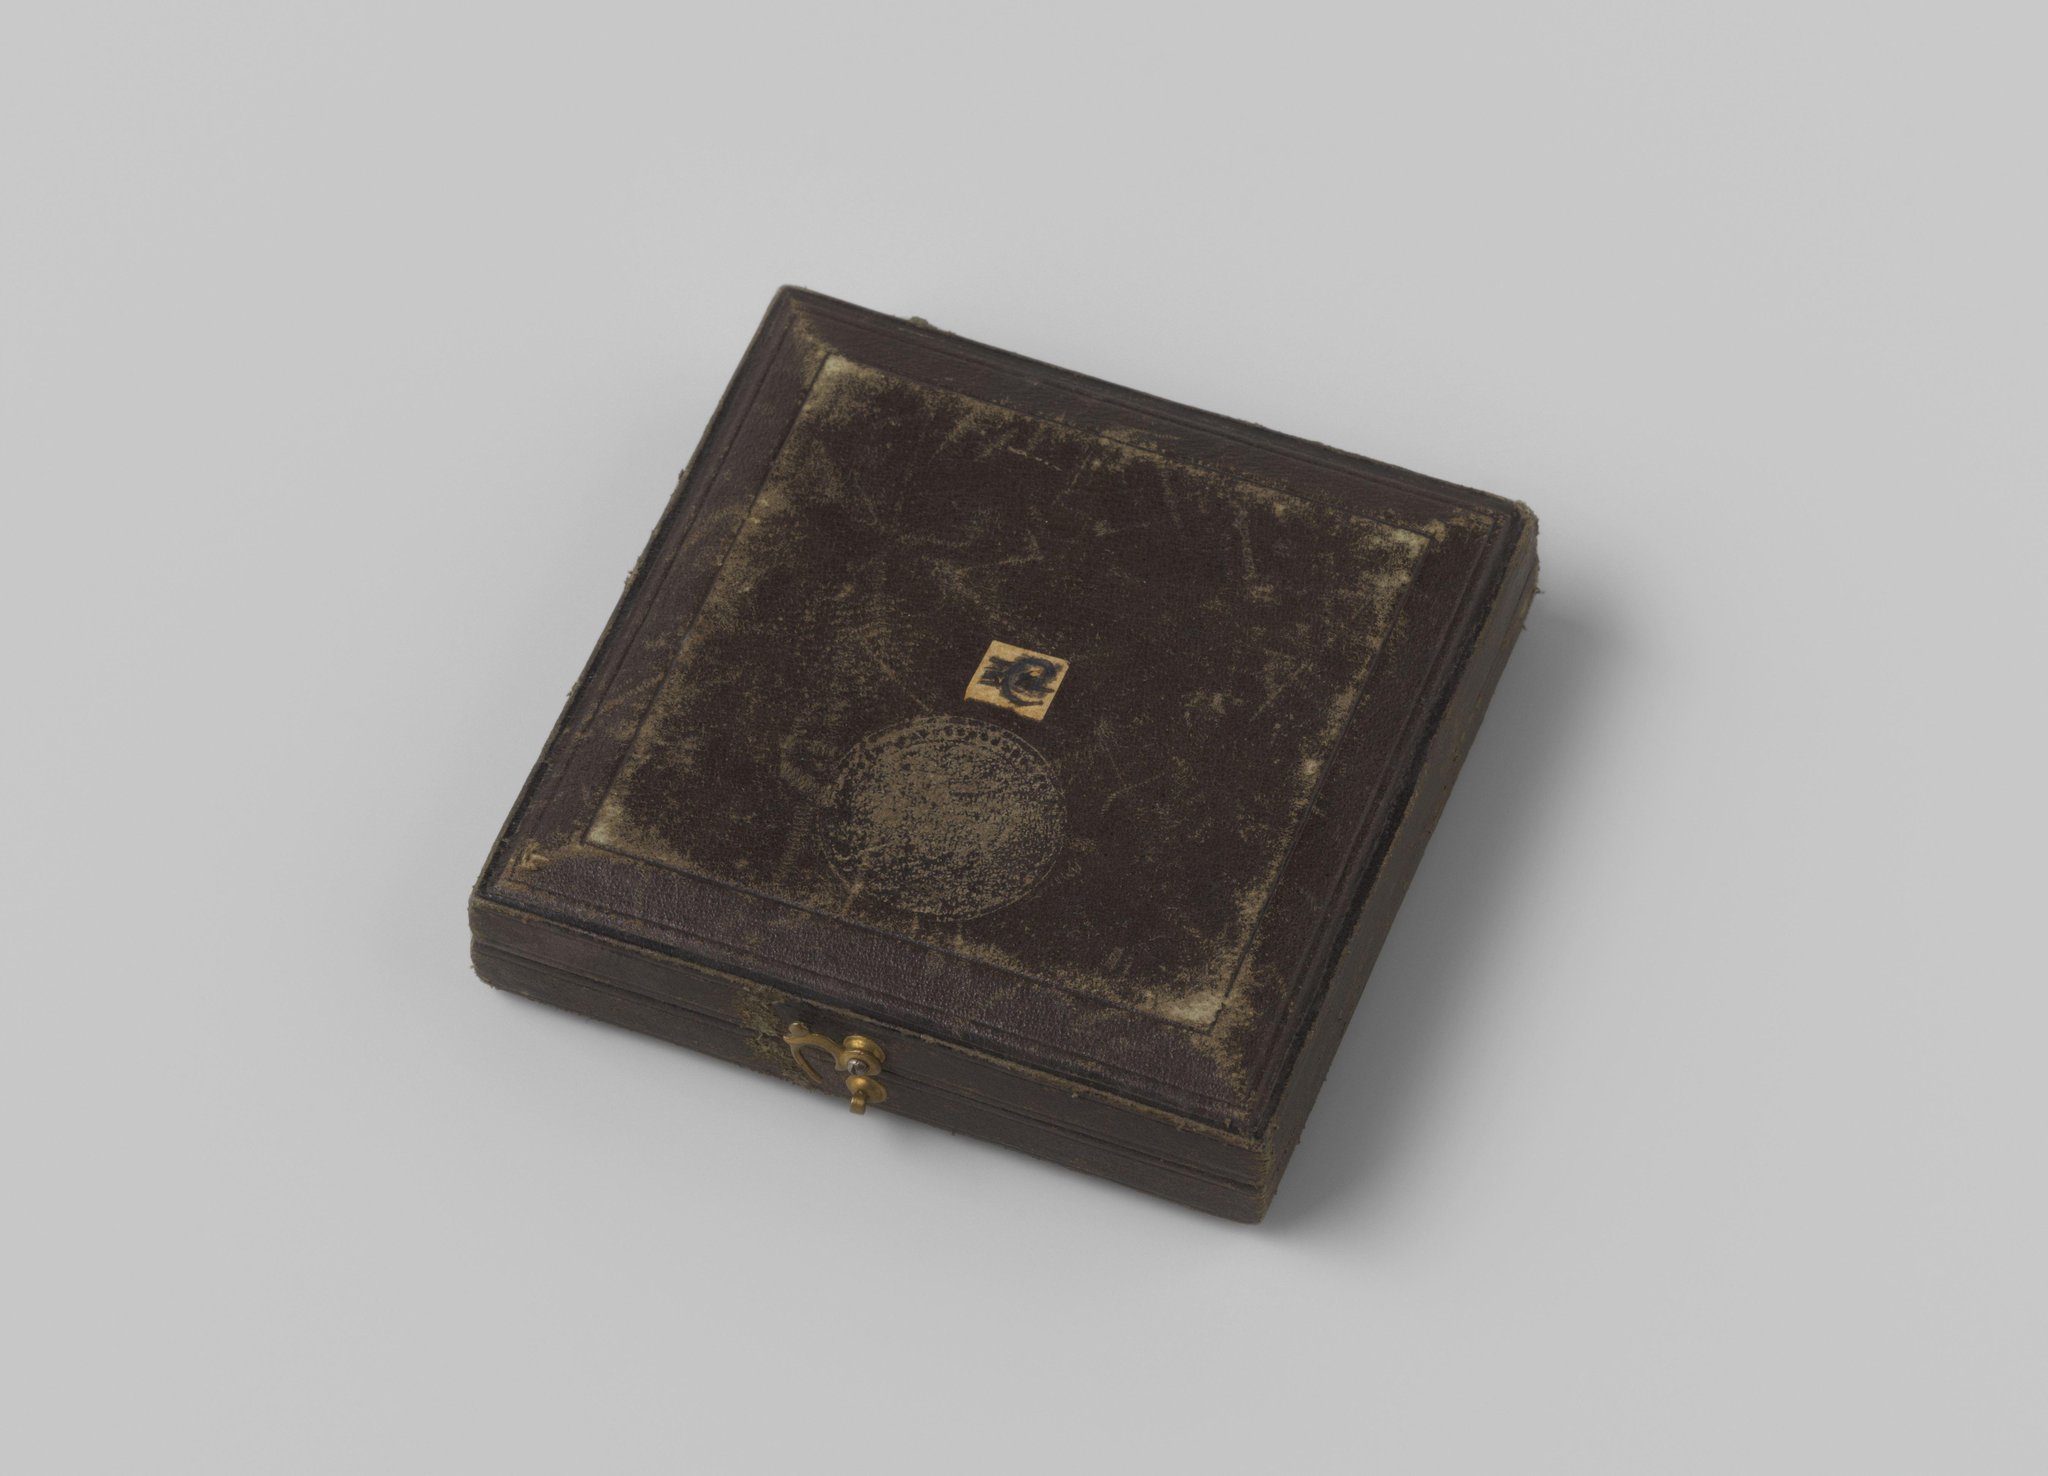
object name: box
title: Doos horend bij een bronzen penning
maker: jacob samuel cohen elion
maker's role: draughtsman, painter, print maker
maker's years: 1840-1893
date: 1883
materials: copper, leather, velvet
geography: amsterdam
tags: mayor, gijsbert van tienhoven, amsterdam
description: Vierkant leren doosje. De binnenkant is van groen fluweel. Het doosje sluit door middel van een koperen haakje.